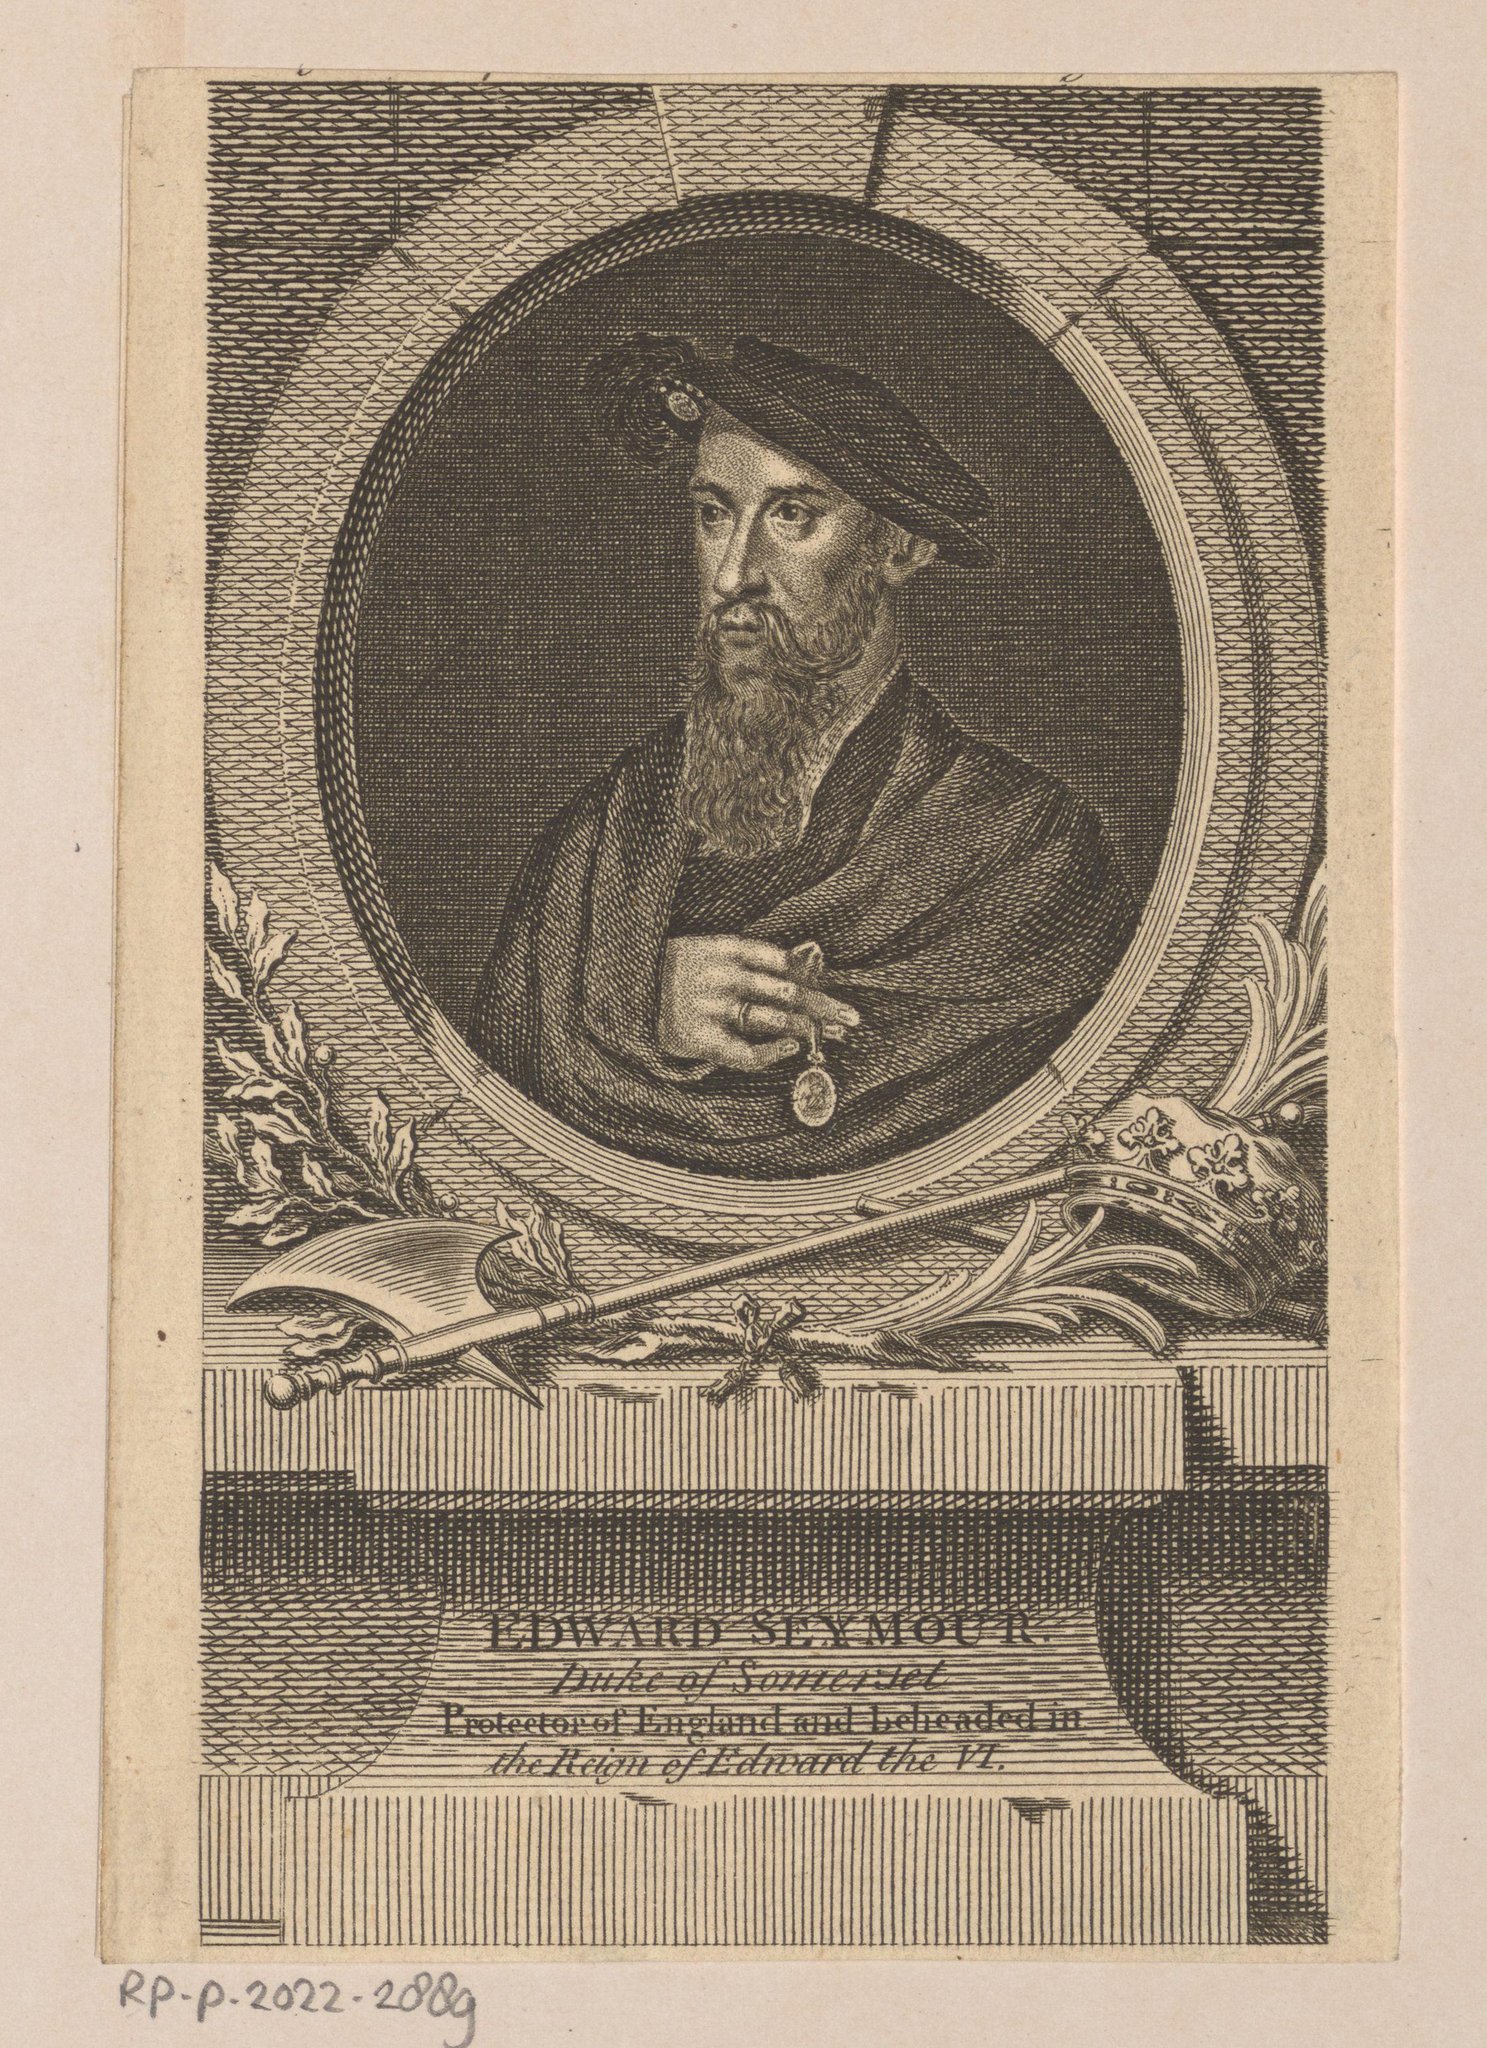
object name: print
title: Portret van Edward Seymour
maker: Anonymous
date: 1600-1750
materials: paper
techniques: engraving, etching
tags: historical persons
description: Met drieregelig onderschrift in het Engels.